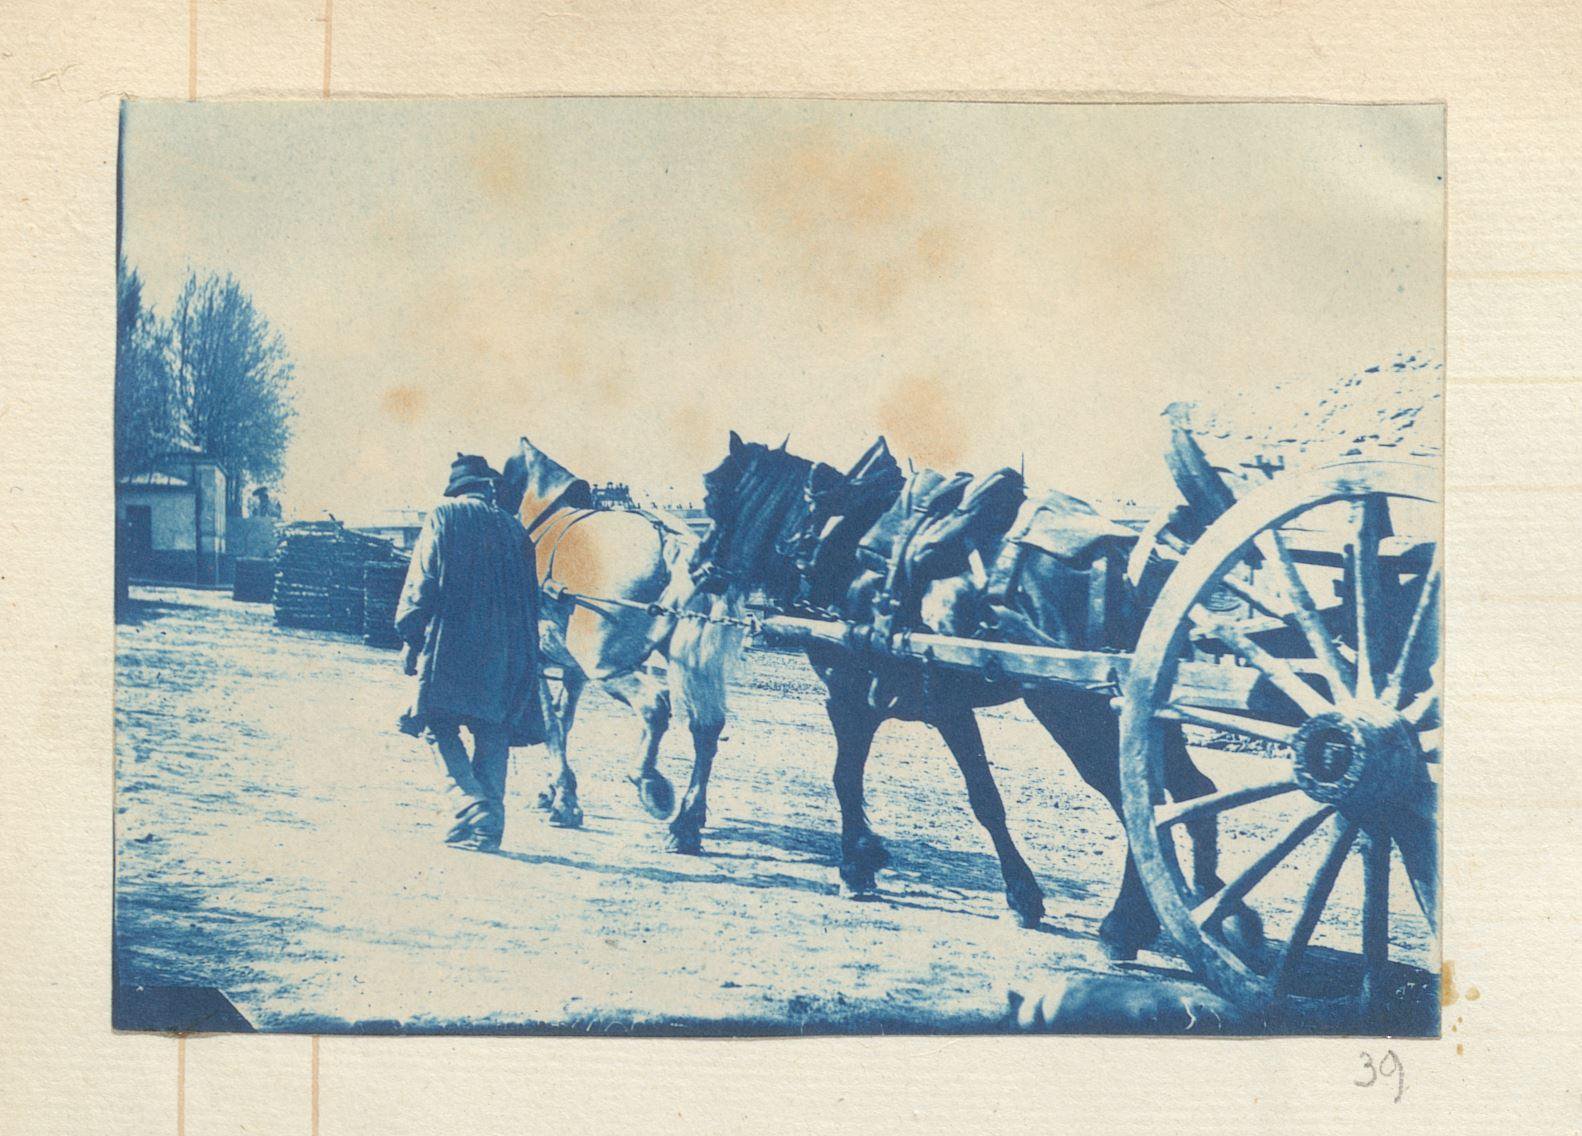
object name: photograph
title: Man loopt naast kar met twee paarden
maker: Anonymous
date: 1880-1900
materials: paper, photographic support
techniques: cyanotype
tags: two-wheeled, animal-drawn vehicle